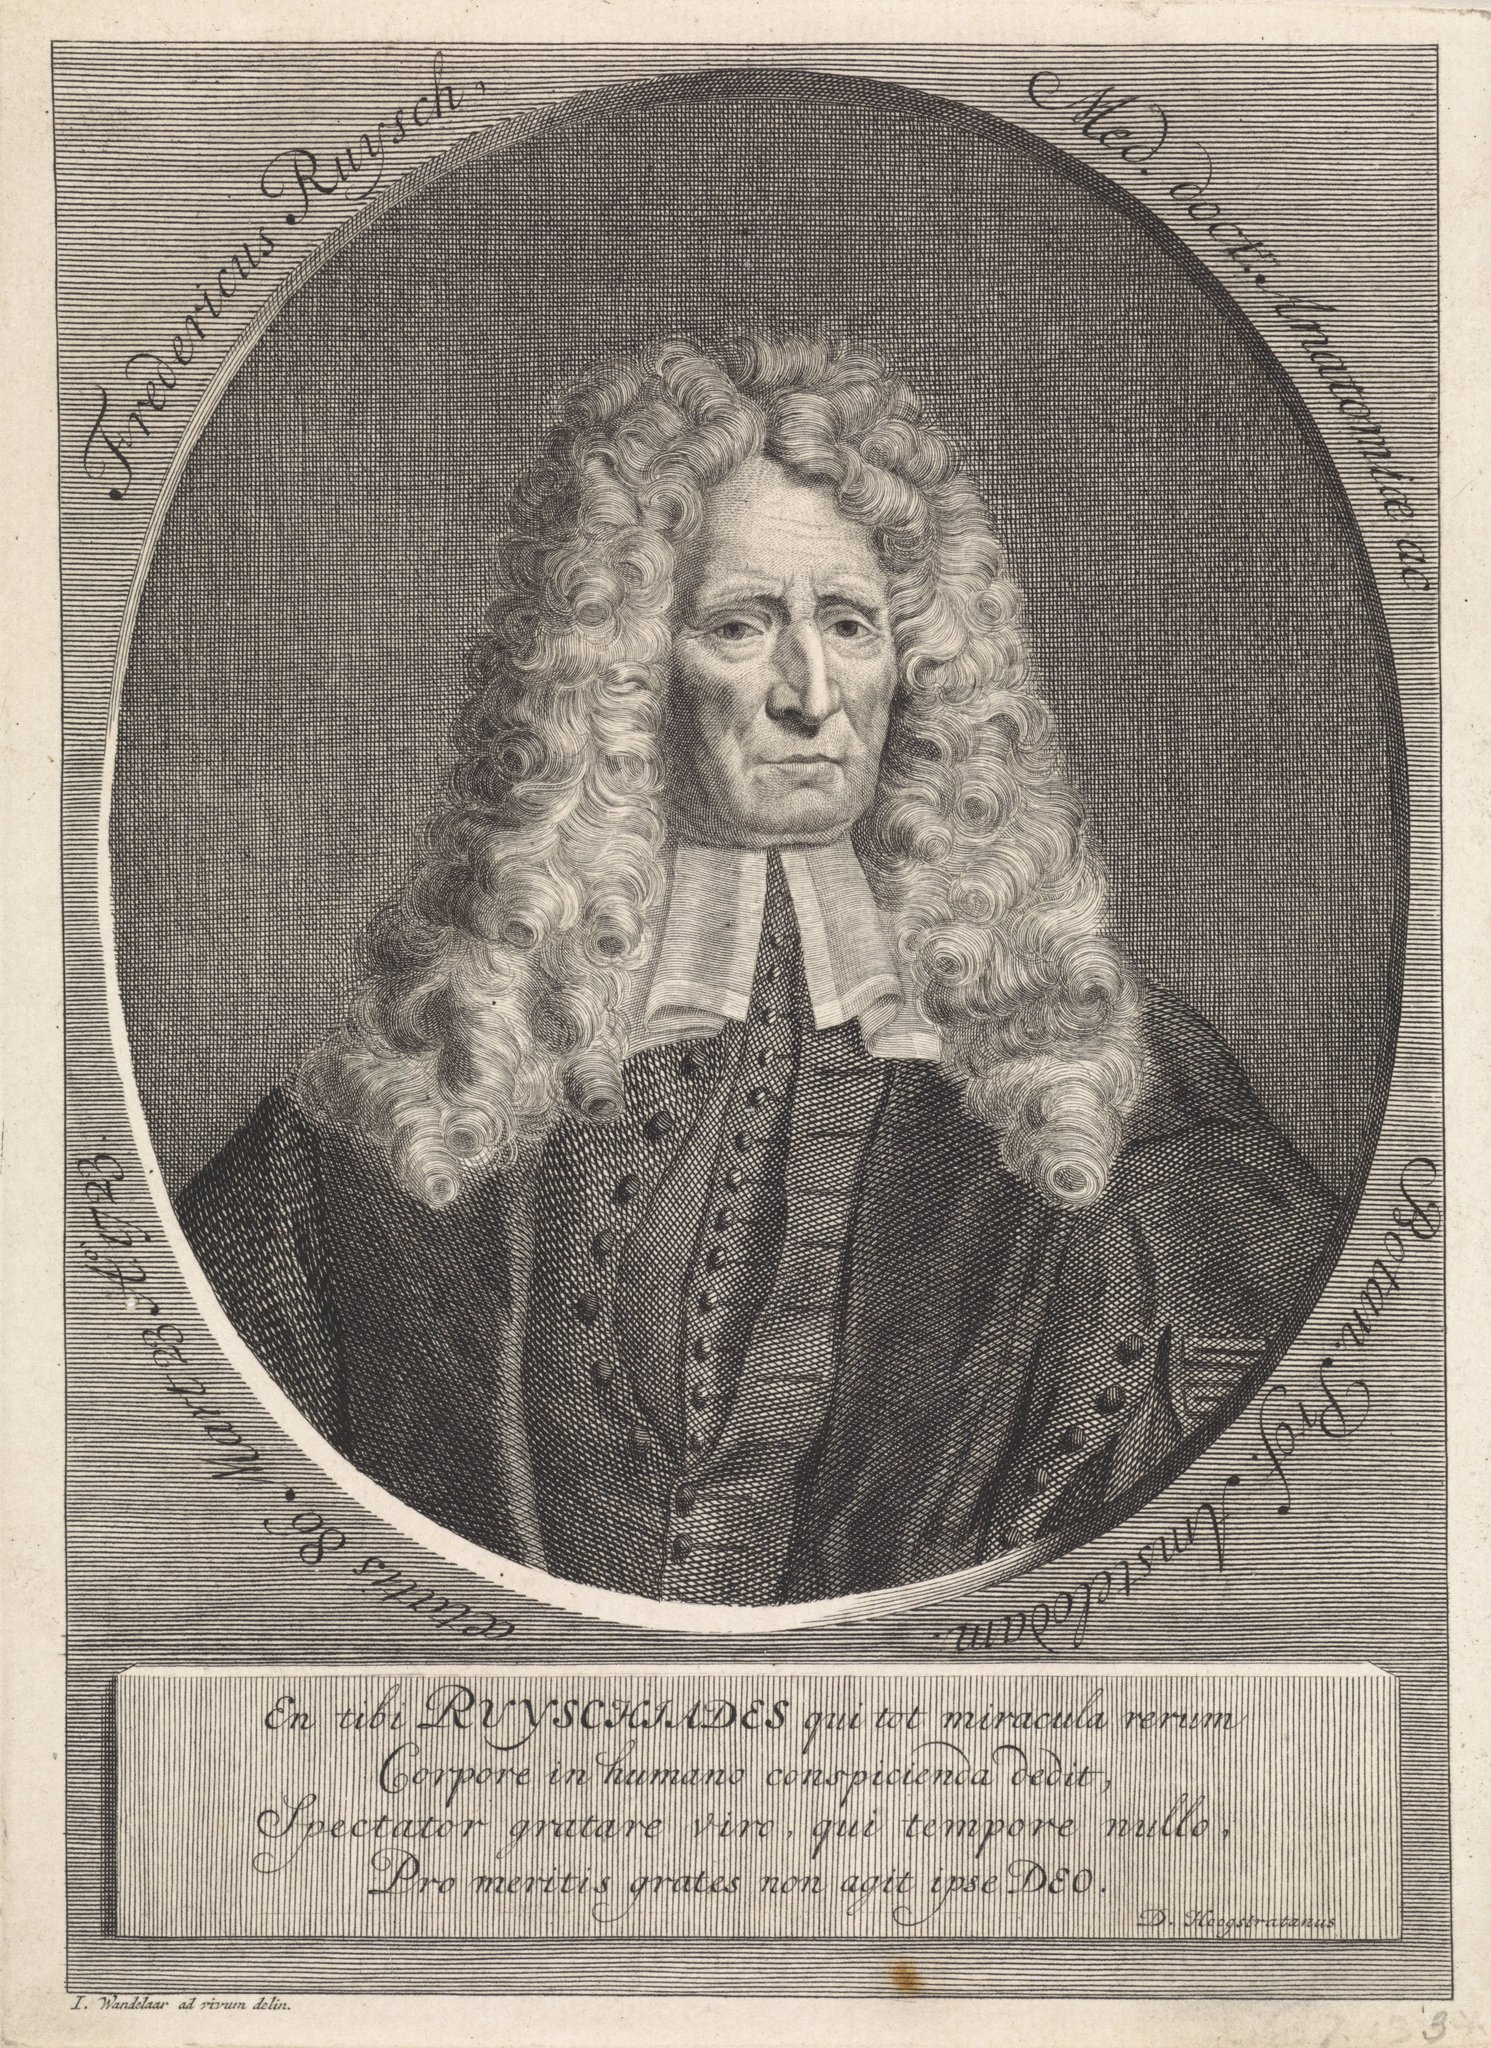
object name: print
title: Portret van de arts en botanicus Frederick Ruysch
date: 1723-1759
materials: paper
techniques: engraving, etching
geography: northern netherlands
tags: the hague, amsterdam, frederik ruysch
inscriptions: collector's mark: Lugt 240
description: In het kader onder zijn portret een vierregelig lofdicht in het Latijn.